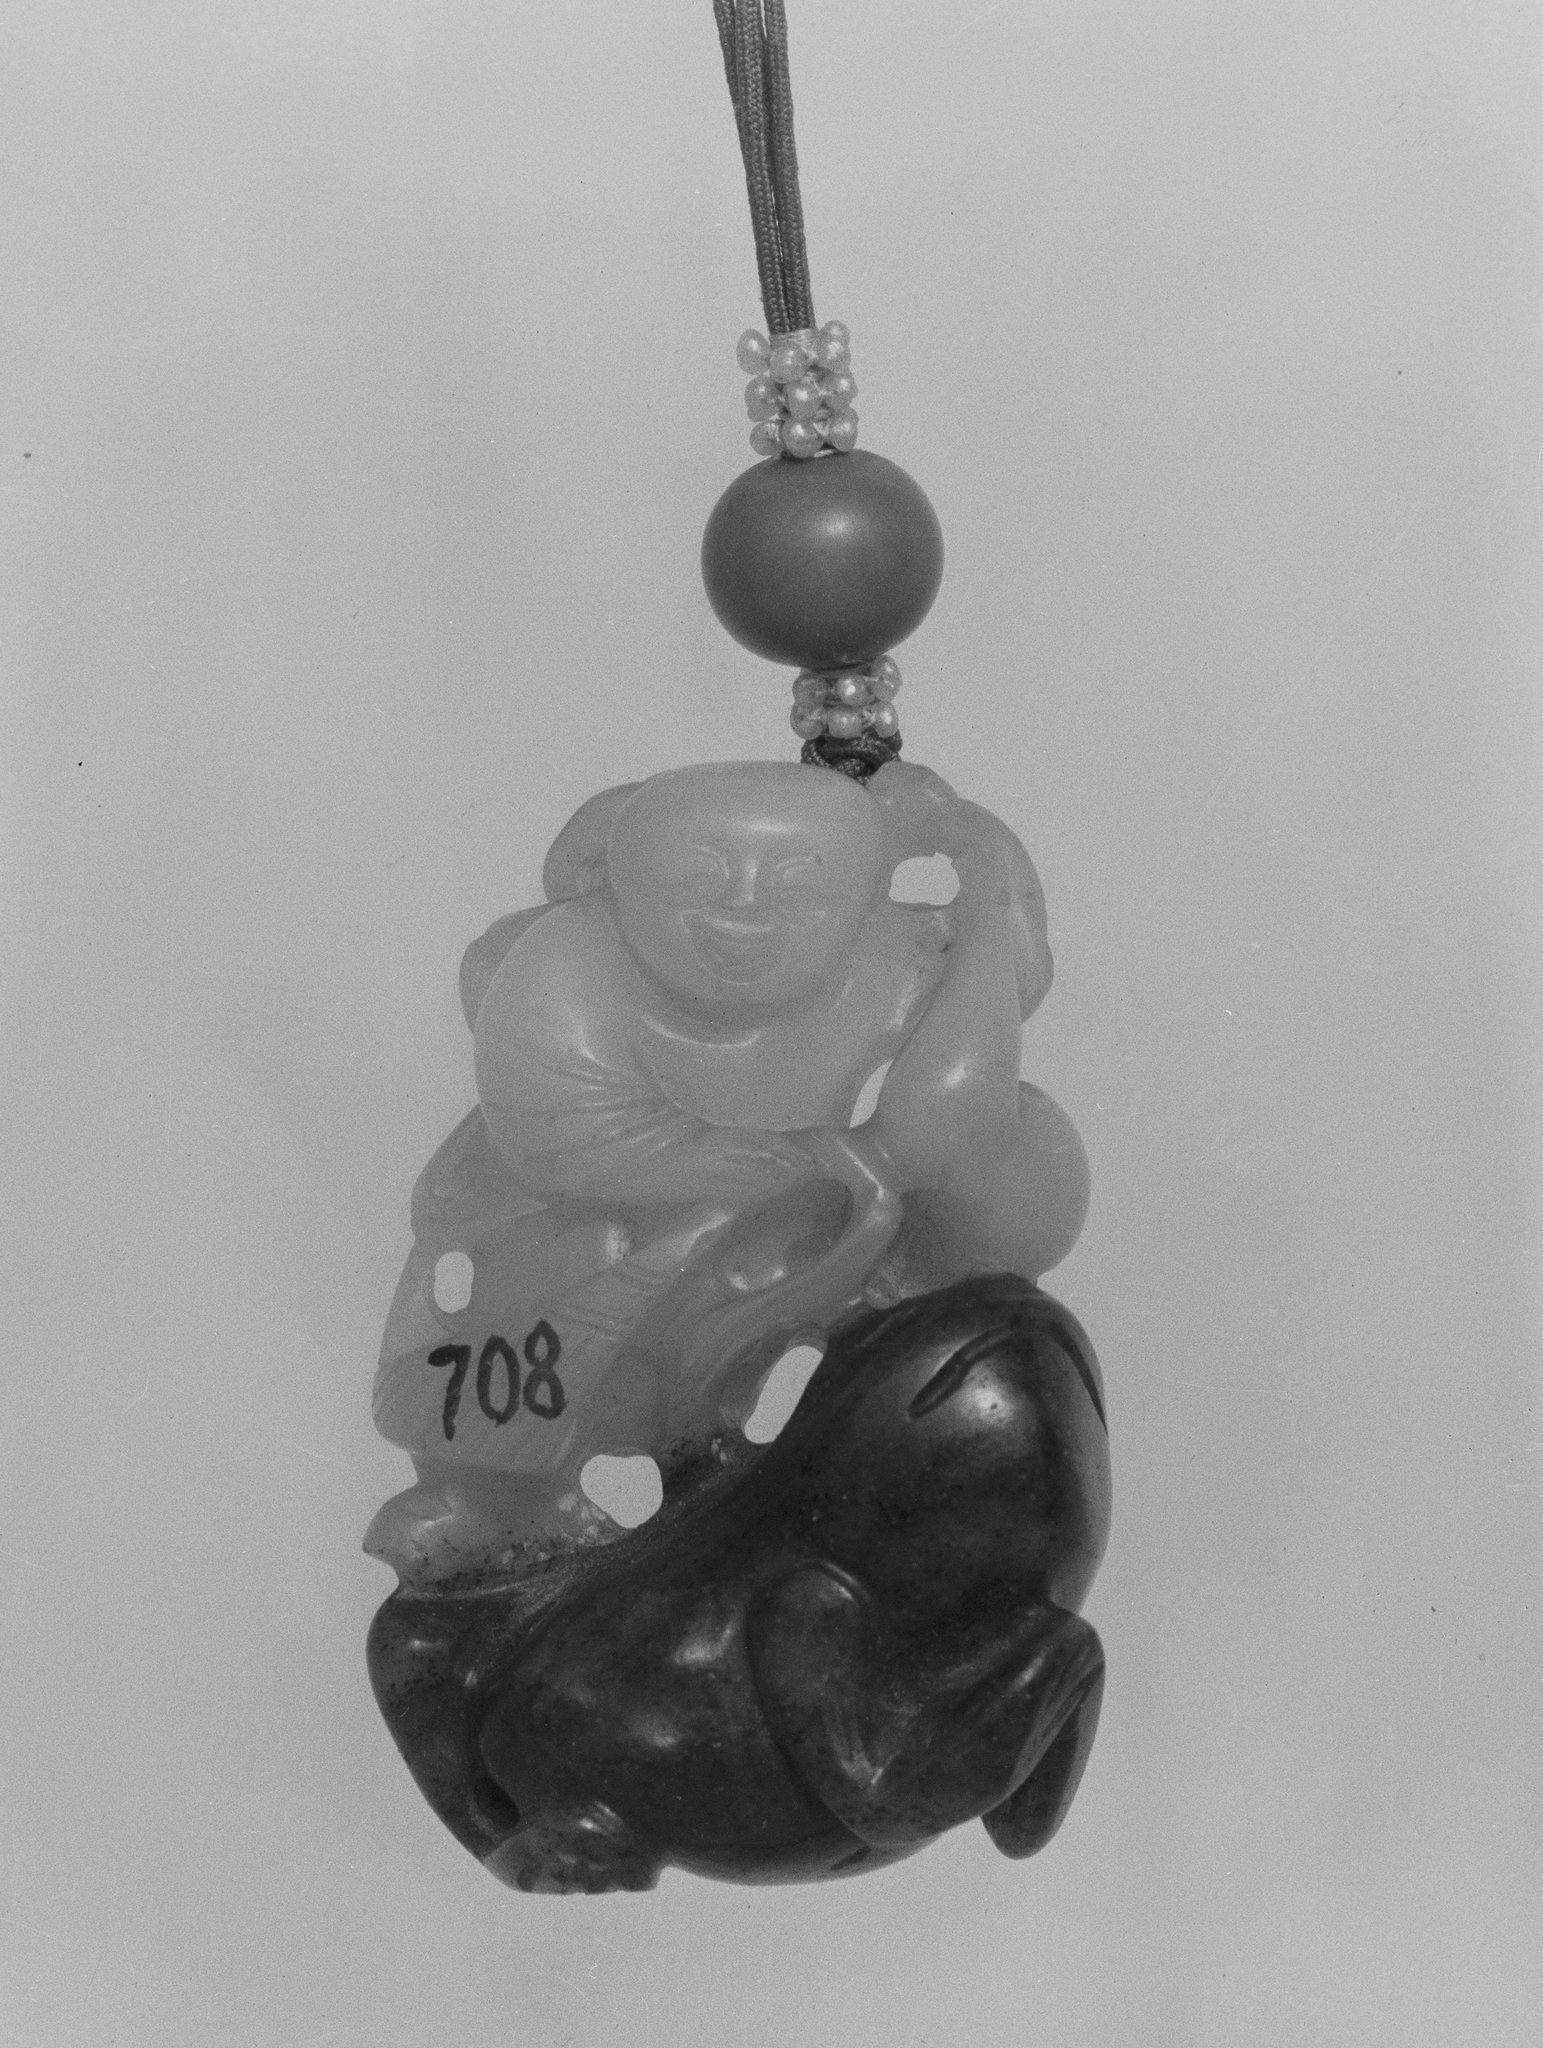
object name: pendant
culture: chinese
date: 1796-1820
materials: jade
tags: animals,men